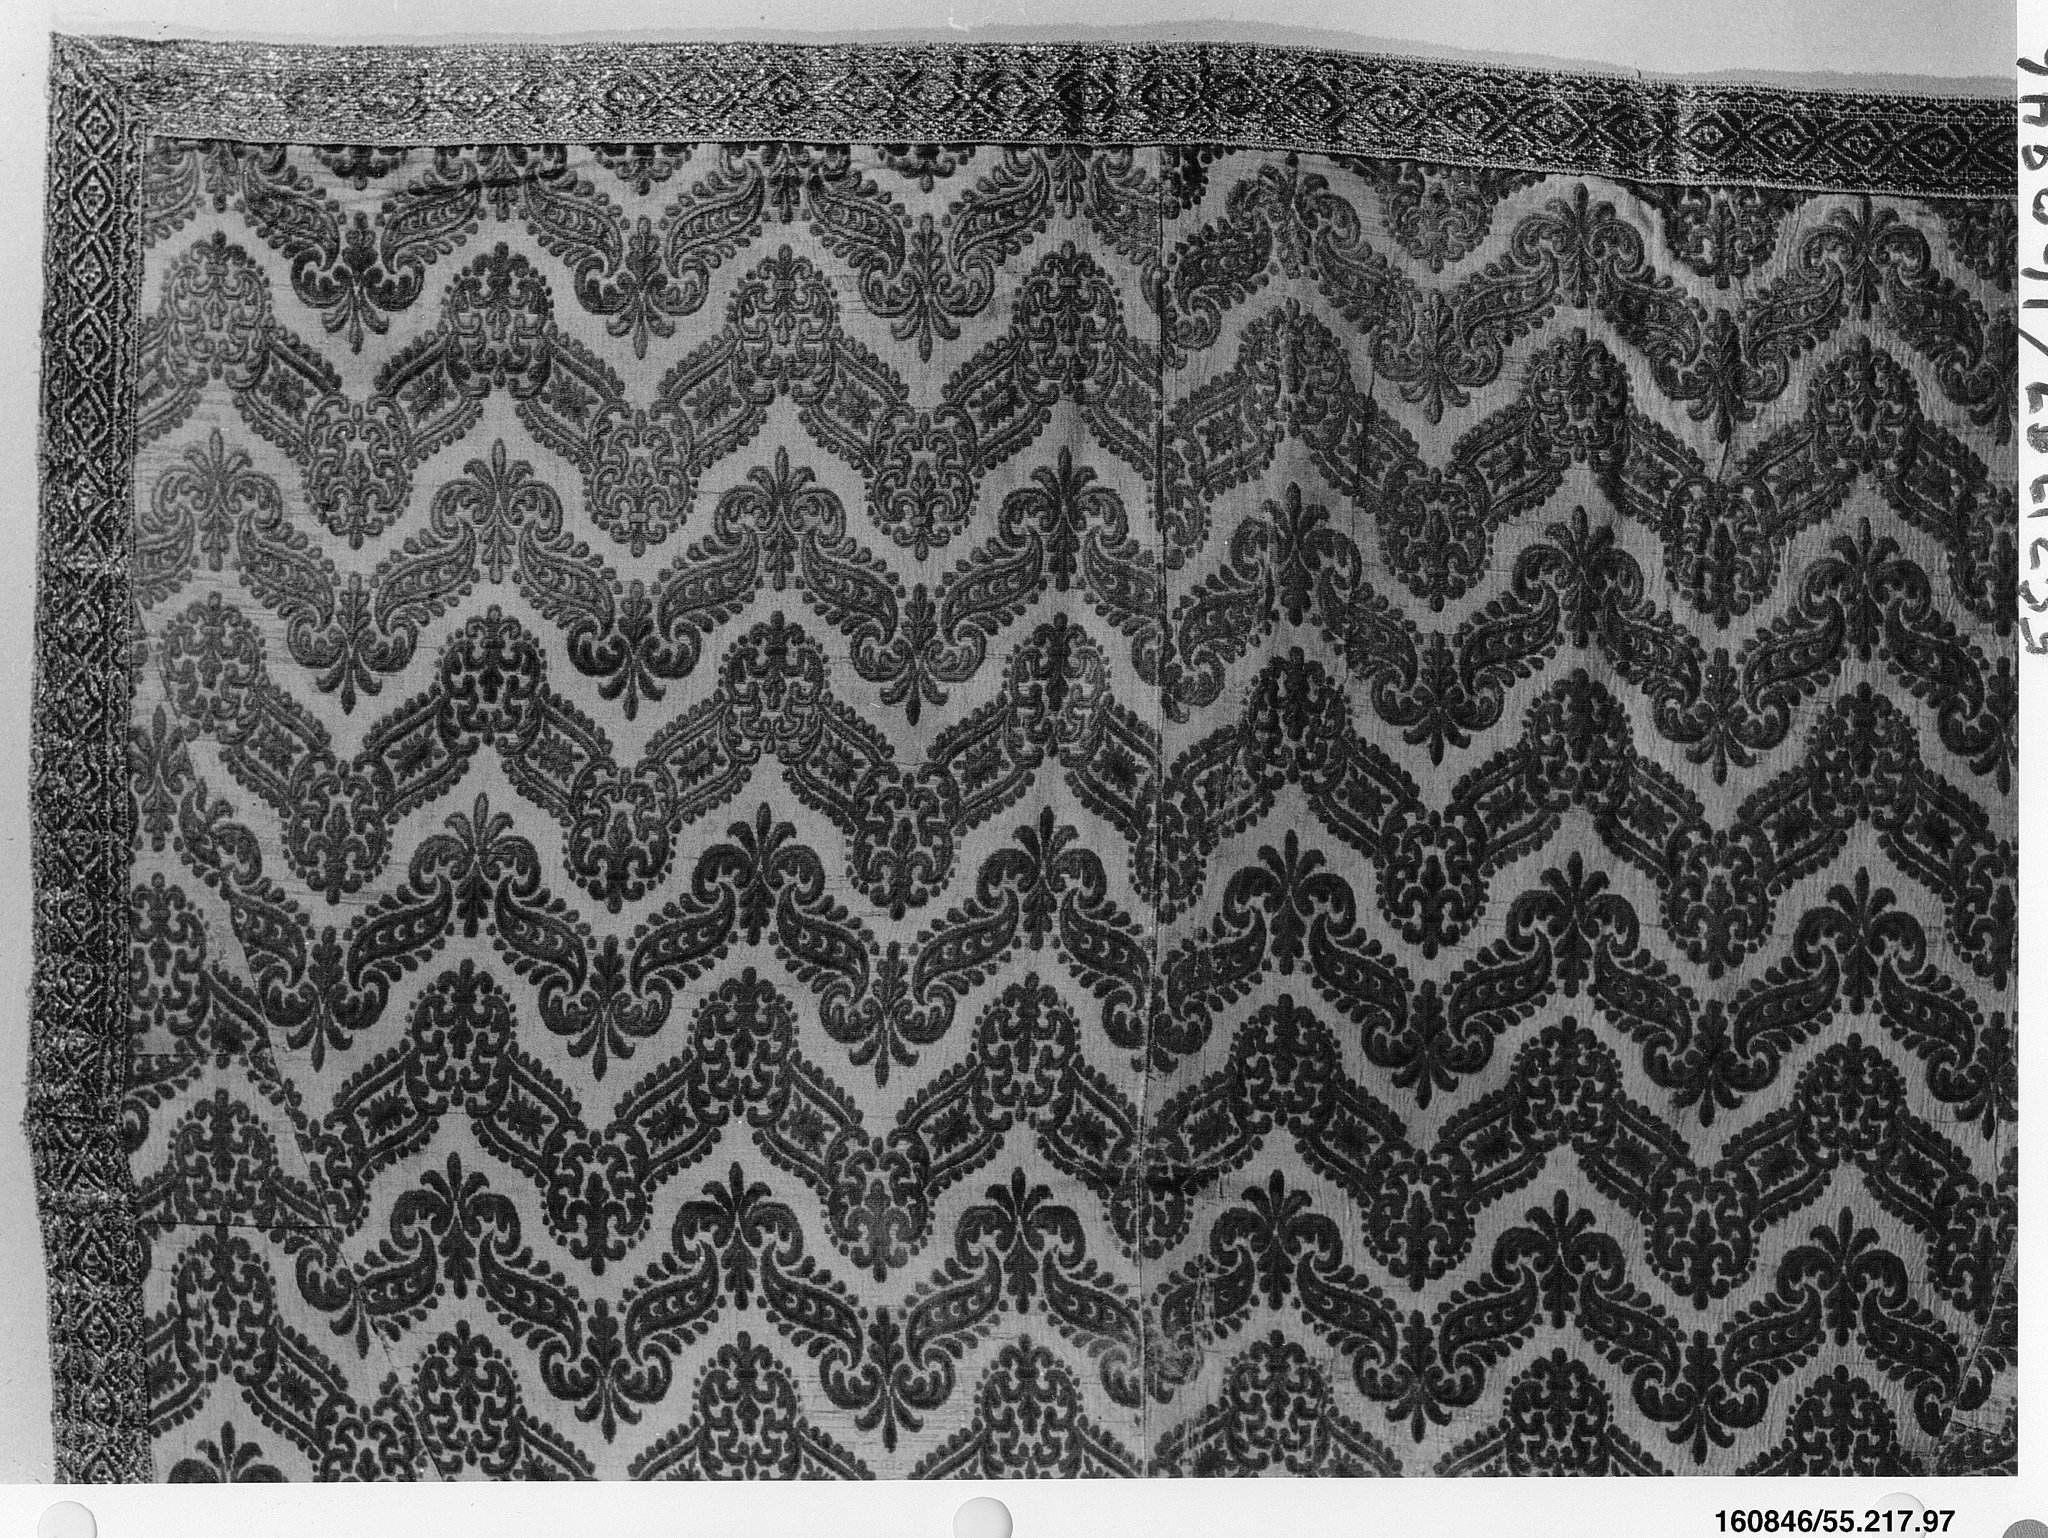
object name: piece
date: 1601-1700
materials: metal thread, silk